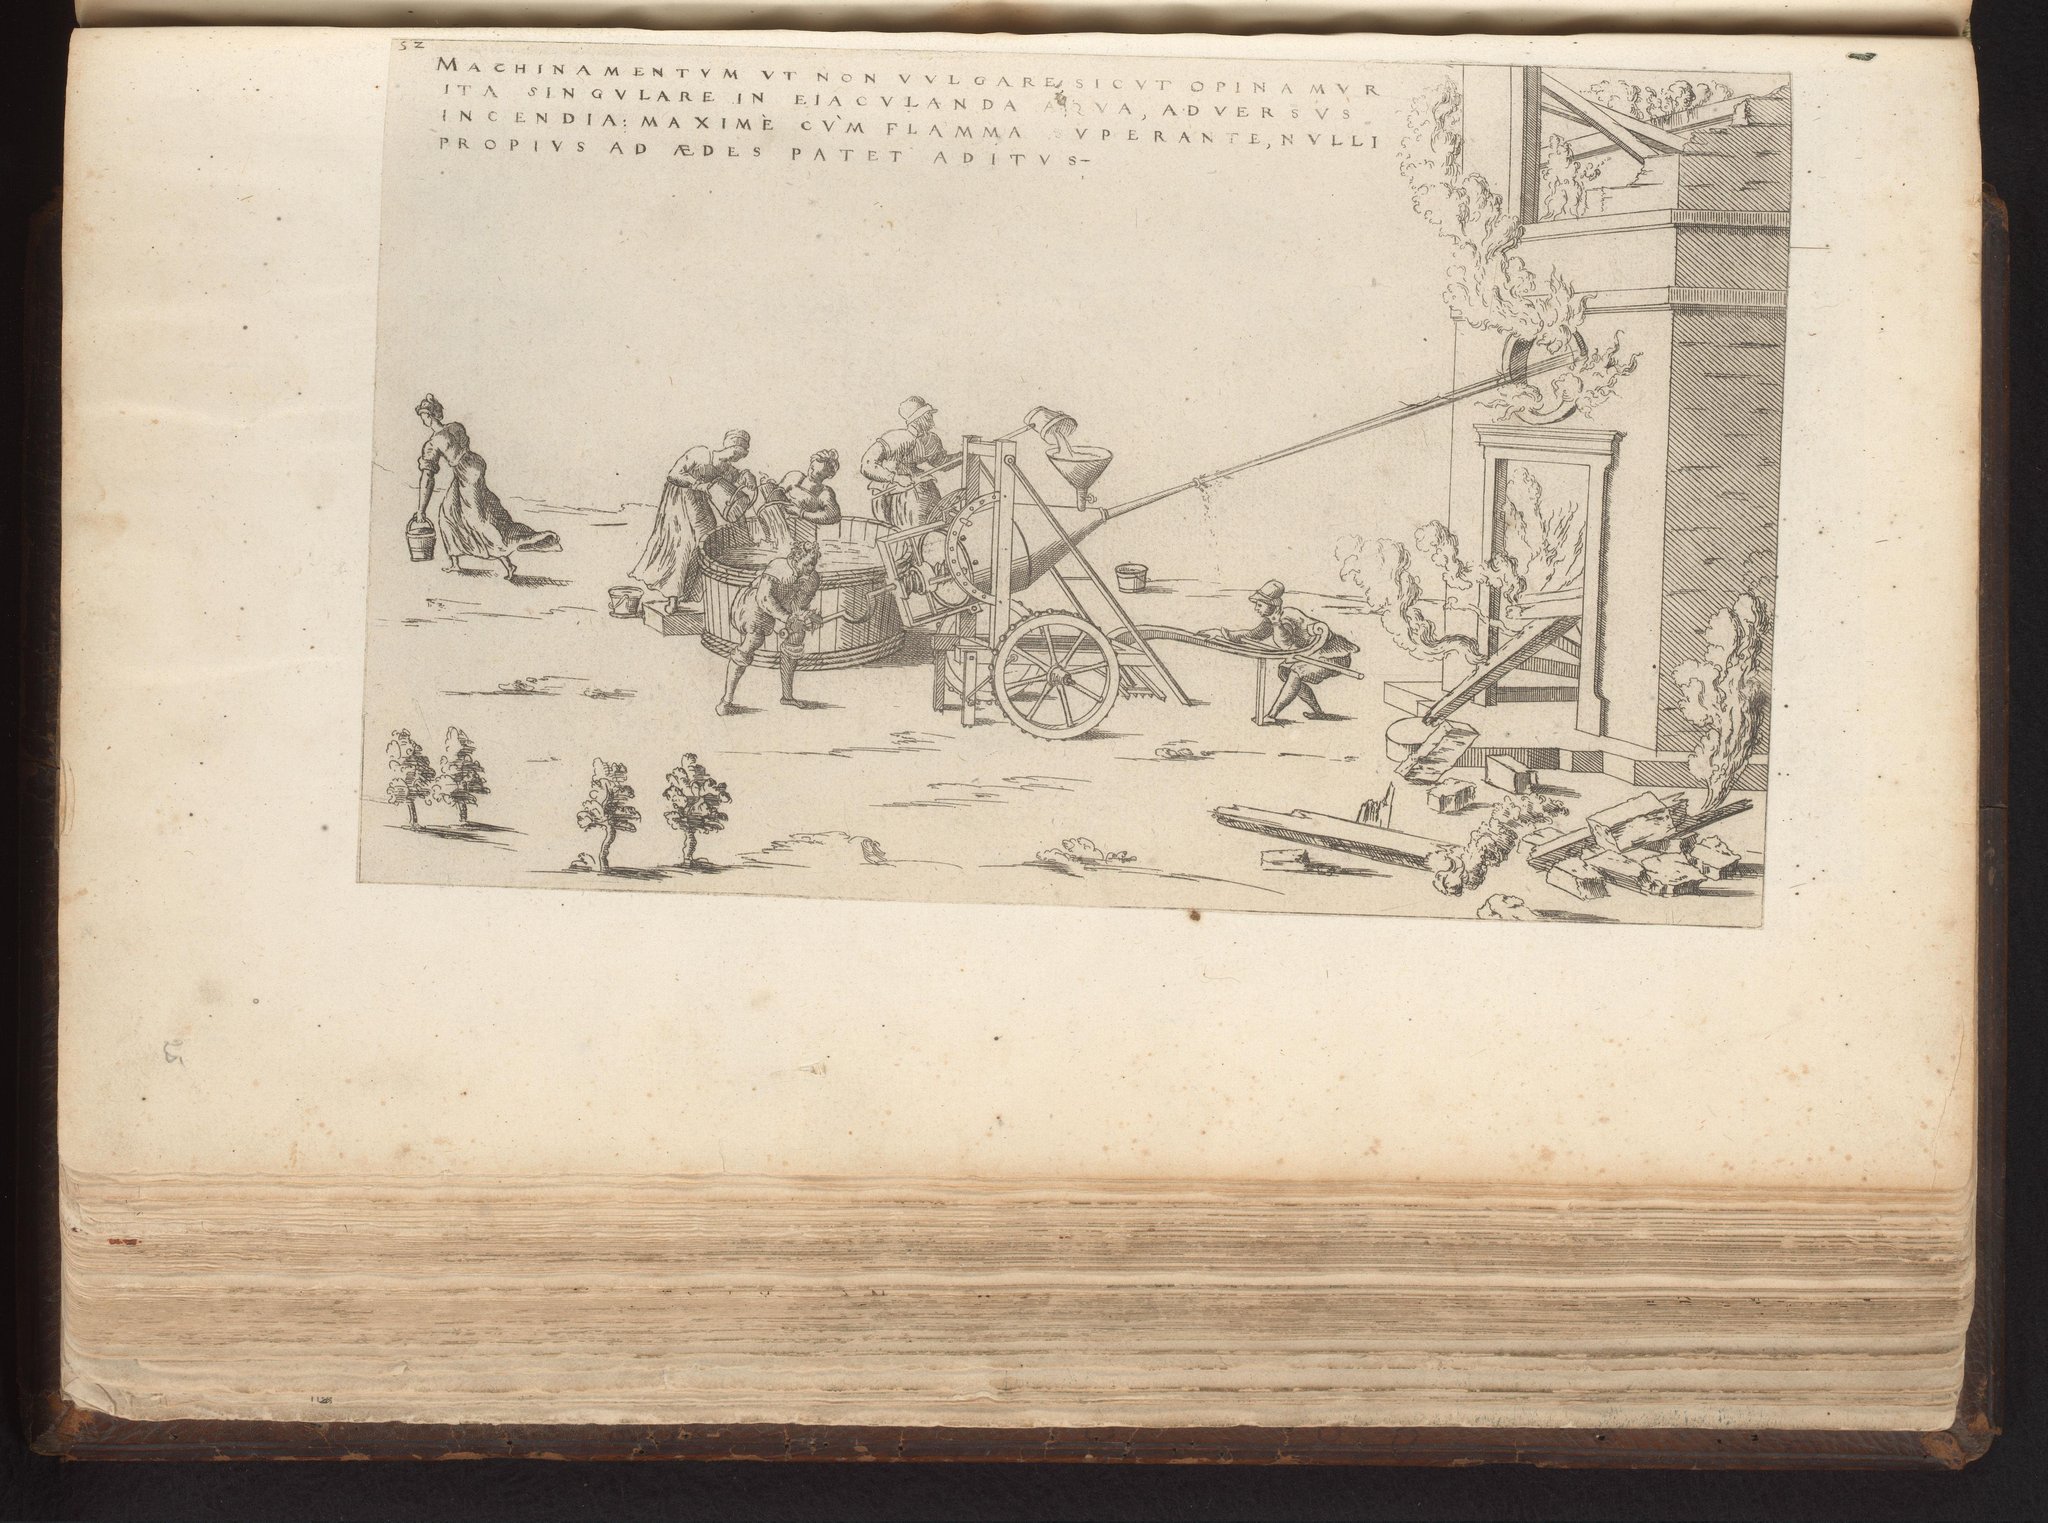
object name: print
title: Mensen blussen een brandend gebouw met een brandblusser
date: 1579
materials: paper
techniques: etching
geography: lyon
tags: extinguishing a fire, fire-fighting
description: Prent uit: Besson, Jacques. Theatre des instrumens mathematiques & mechaniques. Lyon: Barthelemy Vincent, 1579. Prent voor het eerst verschenen in de eerste editie van ca. 1569.